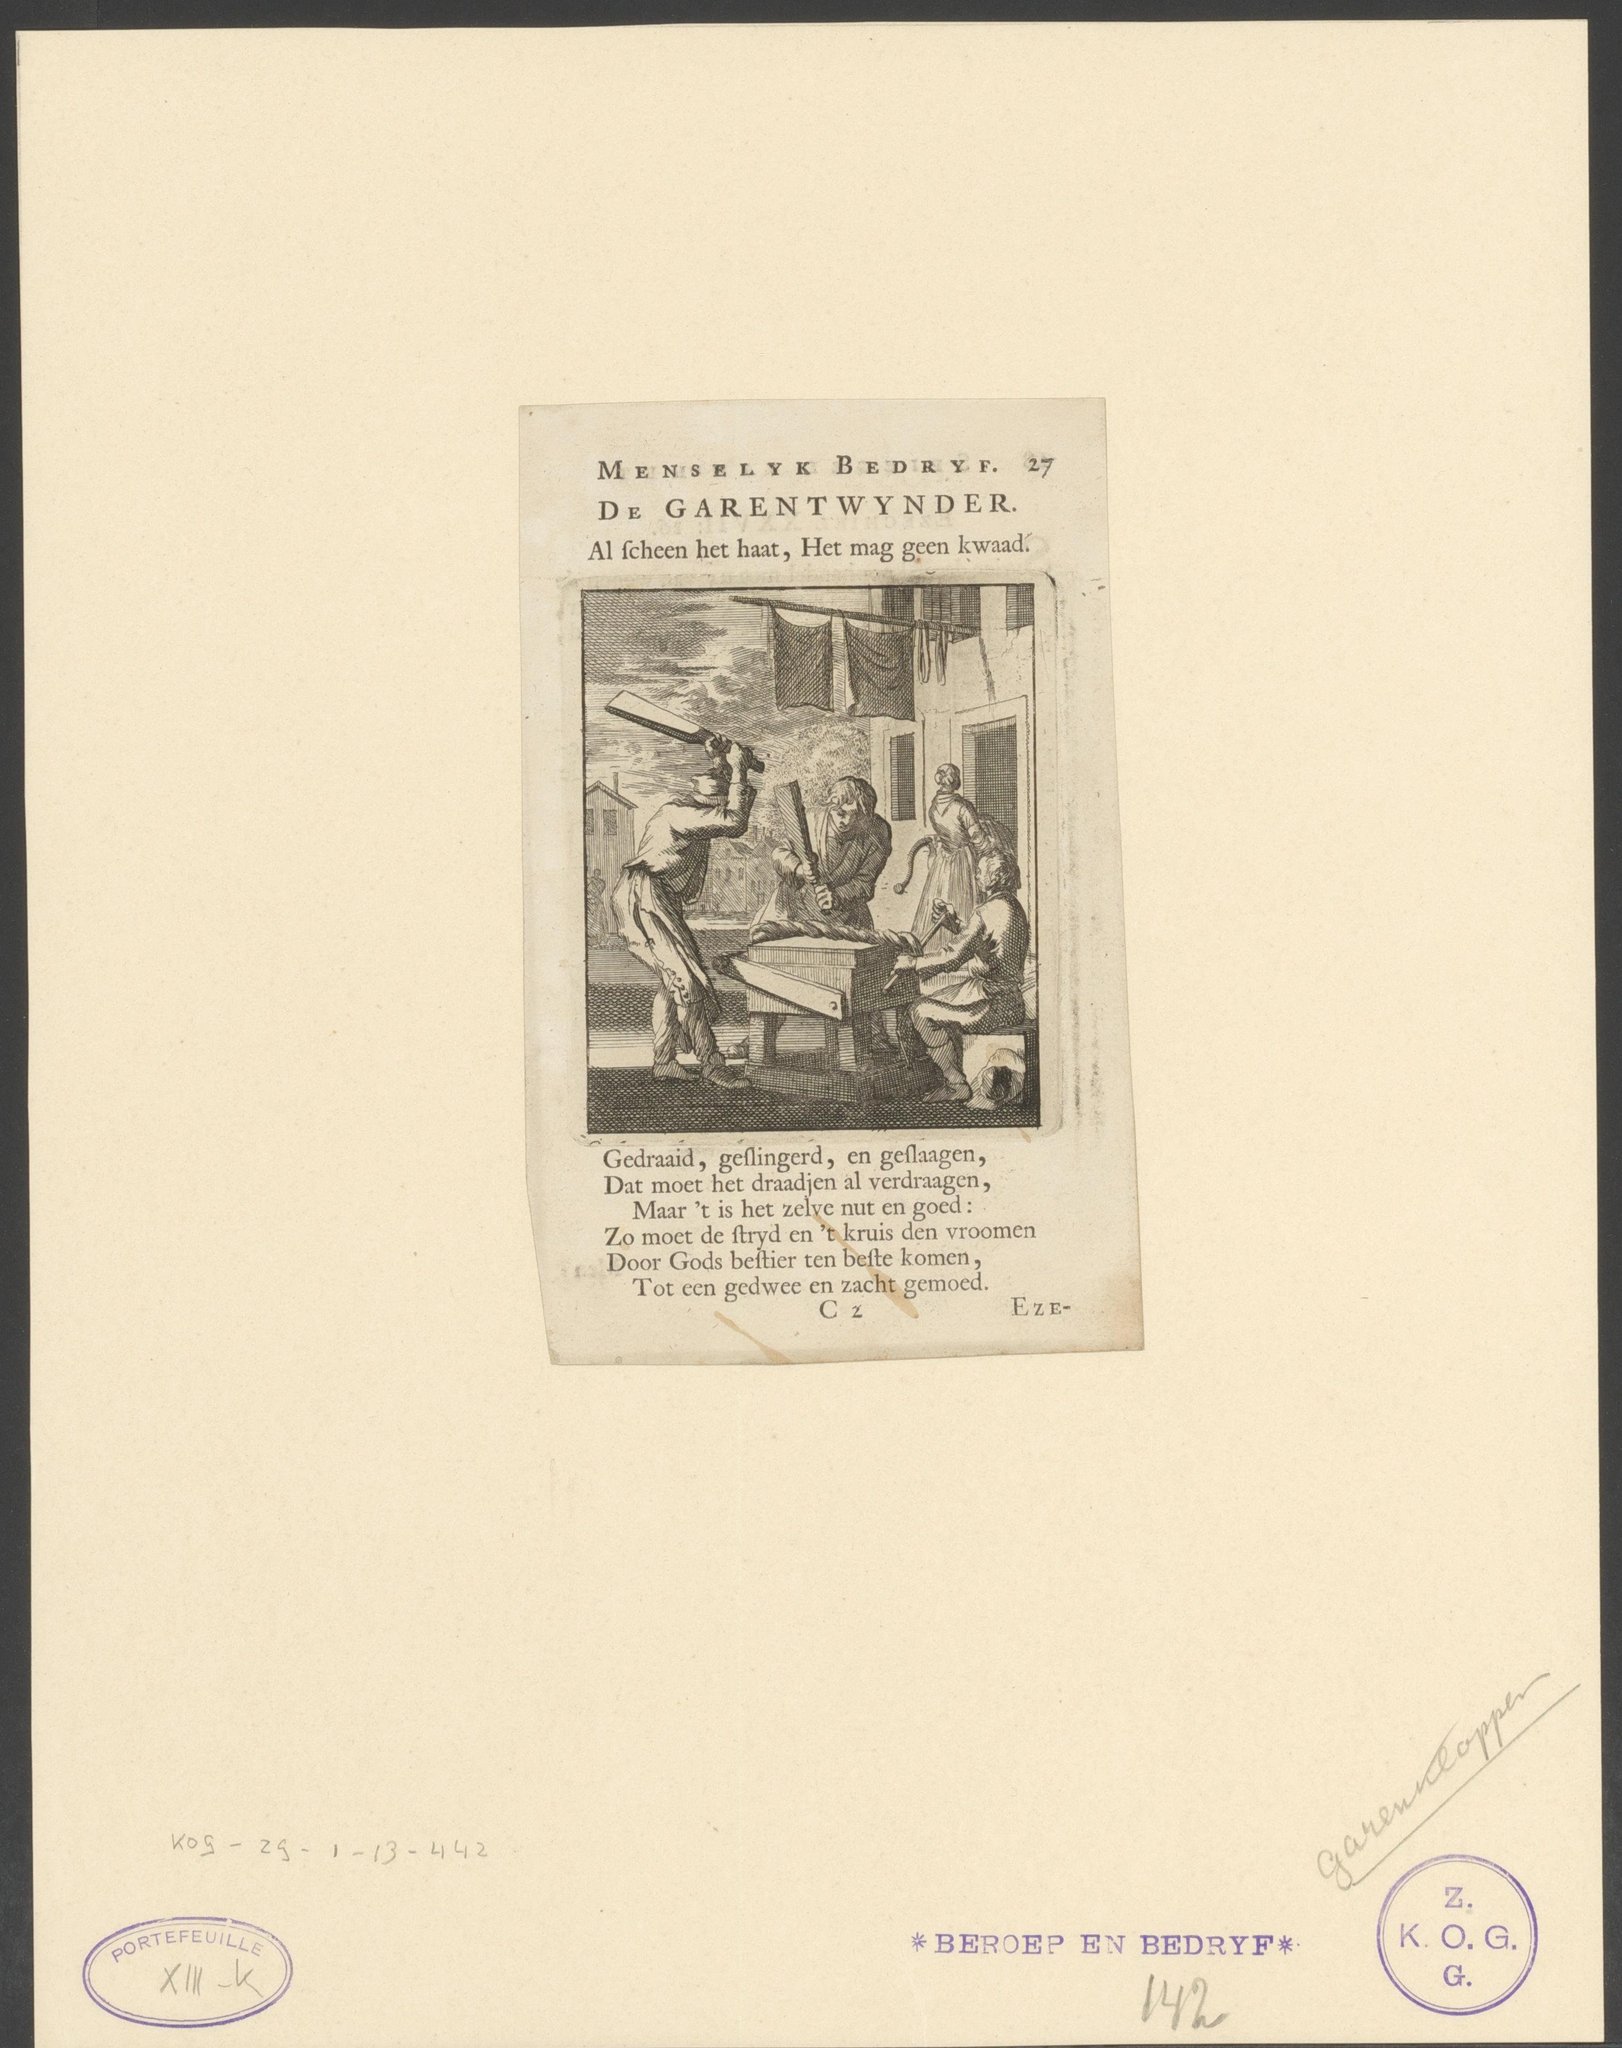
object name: book illustration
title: De Garentwynder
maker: cornelis van der sys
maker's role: publisher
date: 1718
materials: paper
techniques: etching, letterpress printing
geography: amsterdam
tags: handicrafts, craftsman at work, materials ~ textile industry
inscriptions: collector's mark: Lugt 1641, stamp, stamp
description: Prent oorspronkelijk verschenen in de 100-delige serie beroepsprenten van Jan en Caspar Luyken, getiteld: Het menselyk bedryf. S.l.s.n., 1694 (eerste druk). Daarna is de titel en het vers afgesneden. De prenten in diverse publicaties verschenen en gekopieerd. Huidige staat uit: Luyken, Jan en Caspar. Spiegel van het menselyk bedryf (...). Amsterdam: Cornelis van der Sys, 1718, p. 27. Prent waarschijnlijk ook gebruikt in eerdere (1704) en latere (1730, 1749, 1767) publicaties.